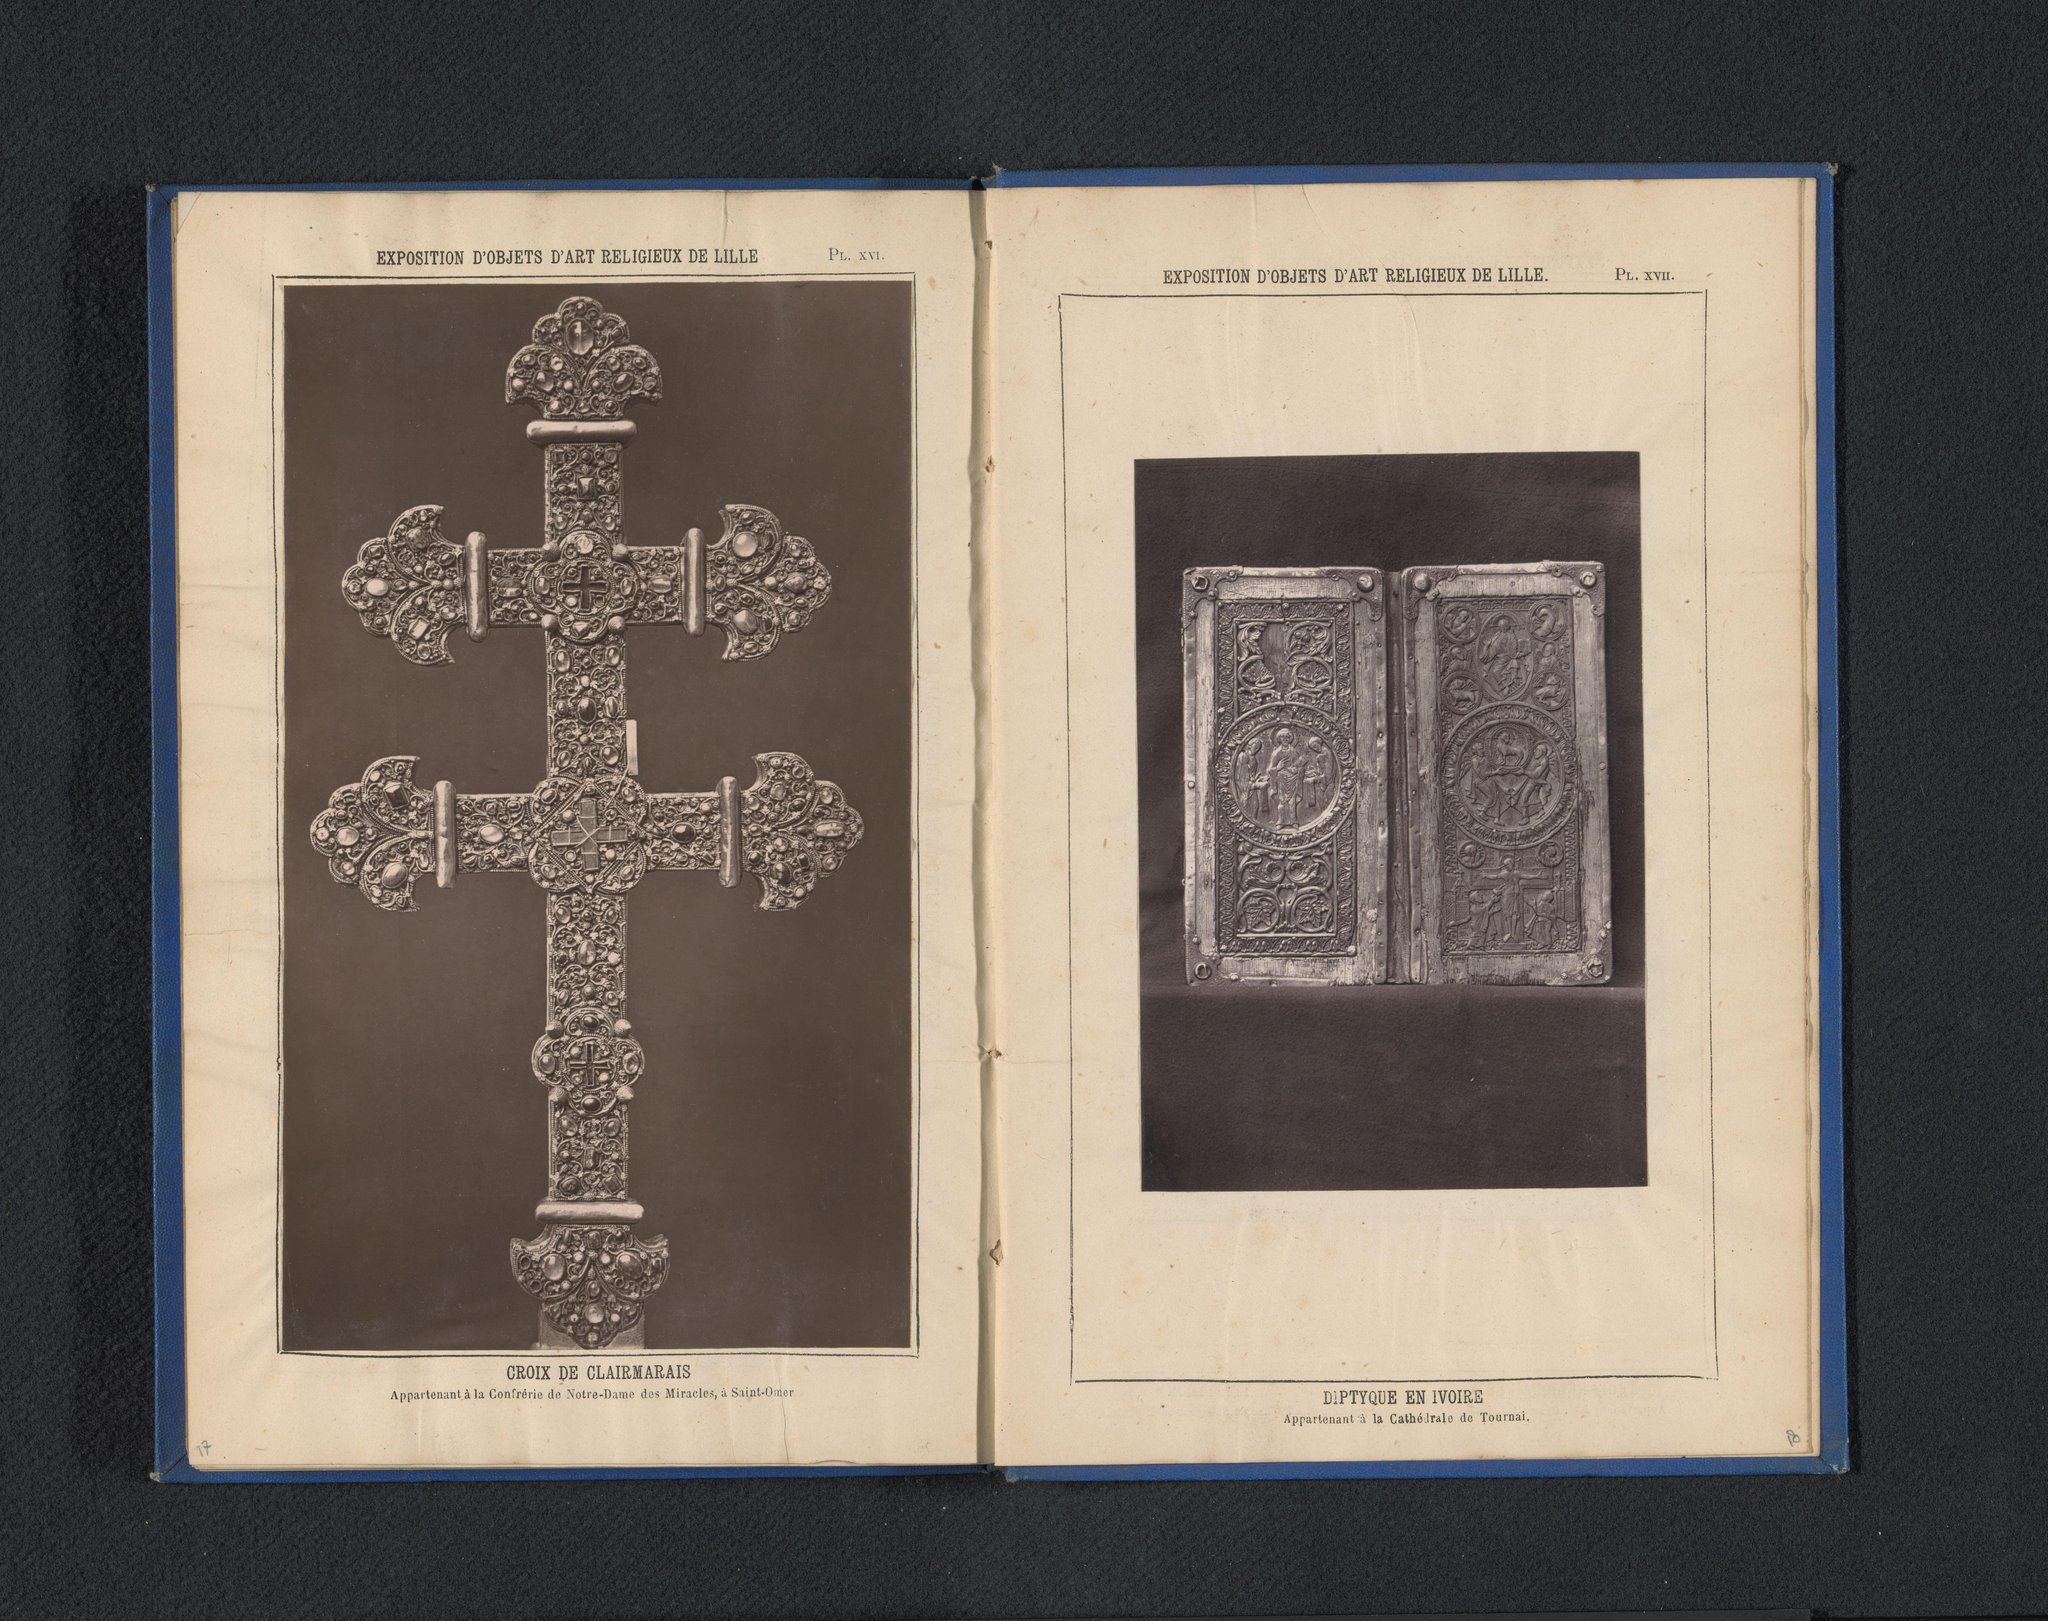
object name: page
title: Dubbel kruis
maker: Anonymous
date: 1871-1876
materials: cardboard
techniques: woodburytype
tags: cross as symbol of christ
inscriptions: inscription: ‘Appartenant à la Confrérie de Notre-Dame des Miracles, à Saint-Omer’, inscription: ‘Exposition d'objets d'art religieux de Lille’, inscription: ‘Pl. XVI.’